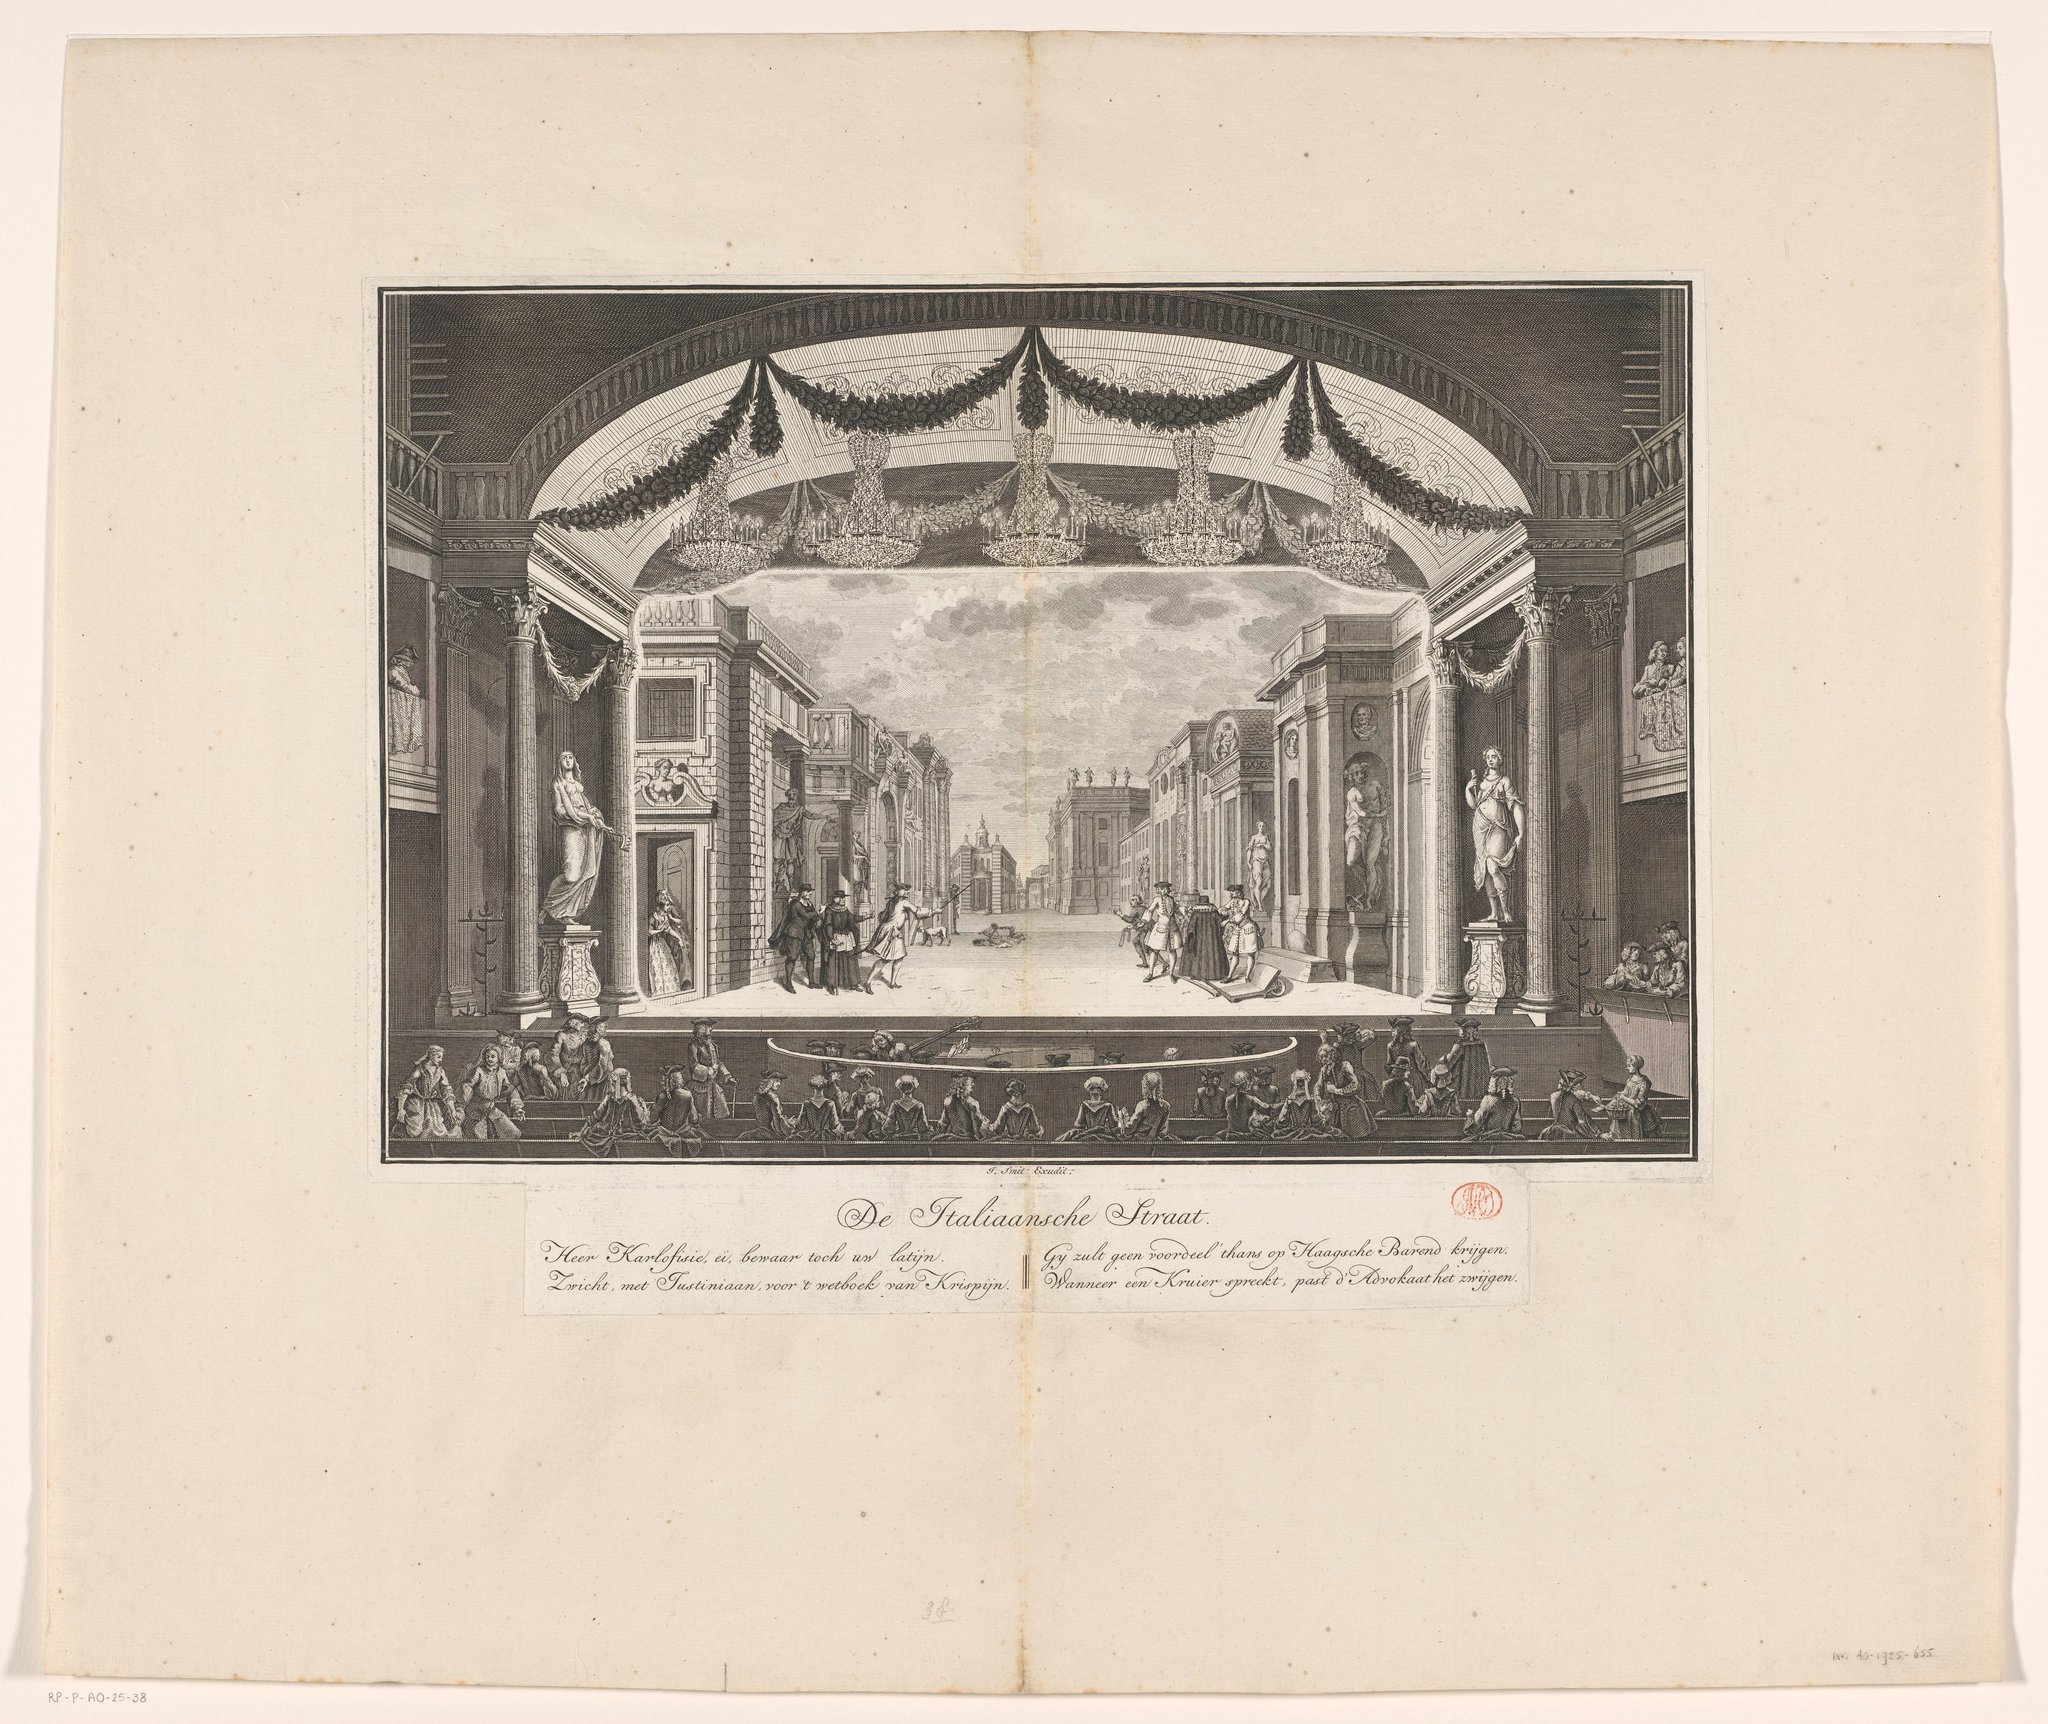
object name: print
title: Toneeldecors van de Amsterdamse Schouwburg, ca. 1760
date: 1736-1738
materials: paper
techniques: engraving, etching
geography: amsterdam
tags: theatre, theatrical performance, stage design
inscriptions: collector's mark: Lugt 195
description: Toneelvoorstelling in de Amsterdamse Schouwburg op de Keizersgracht met het coulissendecor De Italiaansche Straat met scène uit: De Gewaande Advocaat. Het decor gedrukt van een aparte plaat binnen een passe-partout met de zaal, zijloges, orkestbak en de façade van het toneel met zuilen, guirlandes en kroonluchters. De titel en een vierregelig vers ook gedrukt van een aparte plaat. Onderdeel van een serie van 12 toneeldecors.